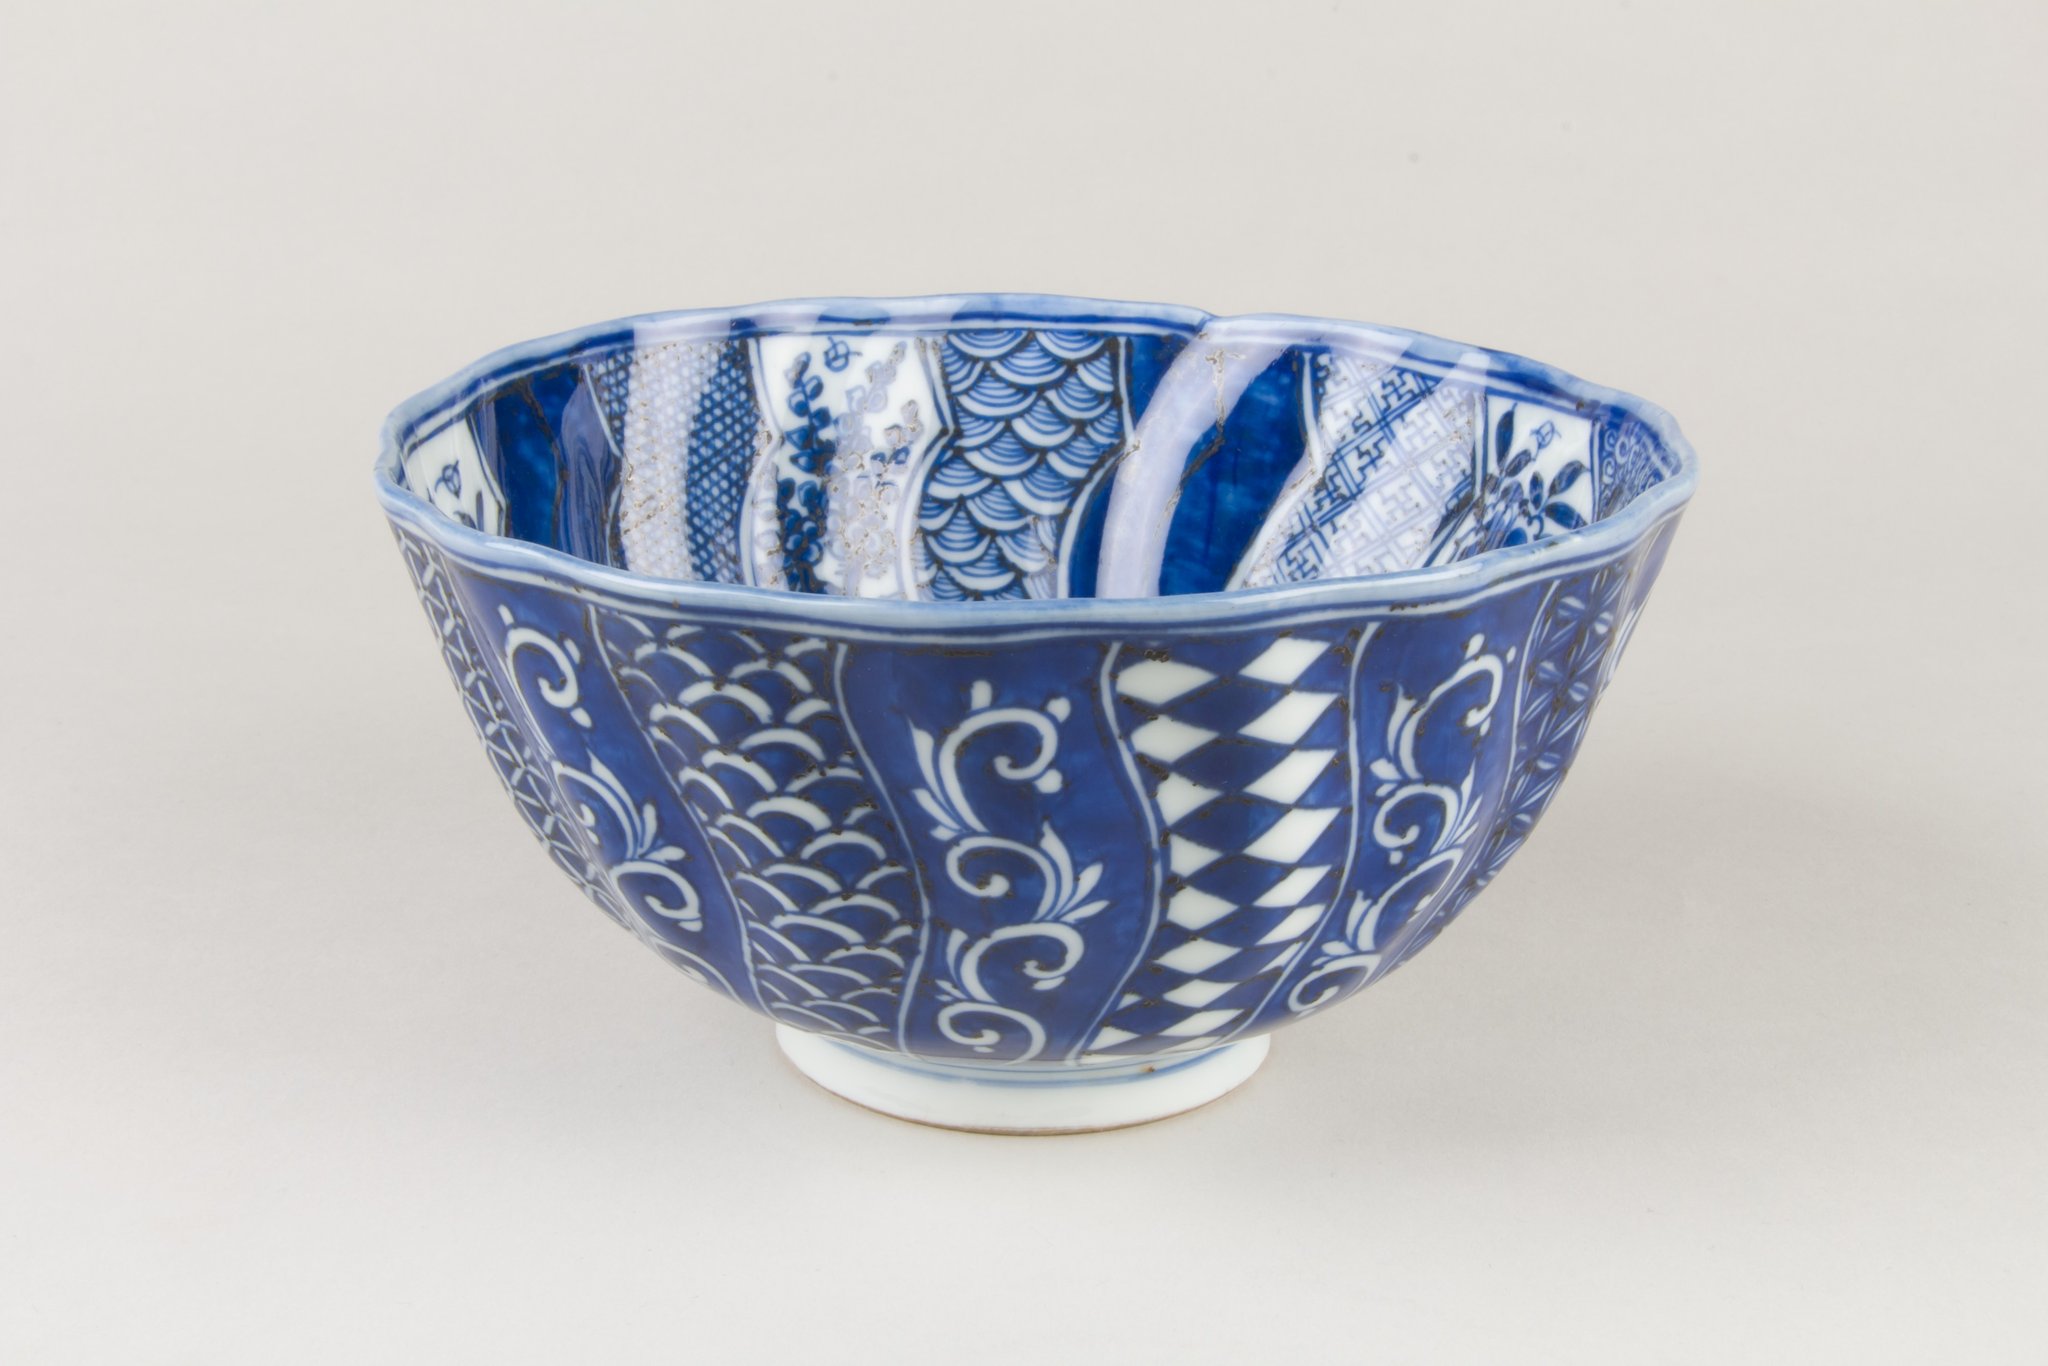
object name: bowl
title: Bowl with geometric pattern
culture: chinese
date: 1634-1666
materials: cobalt, porcelain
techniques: painting, underglaze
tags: flowers,leaves